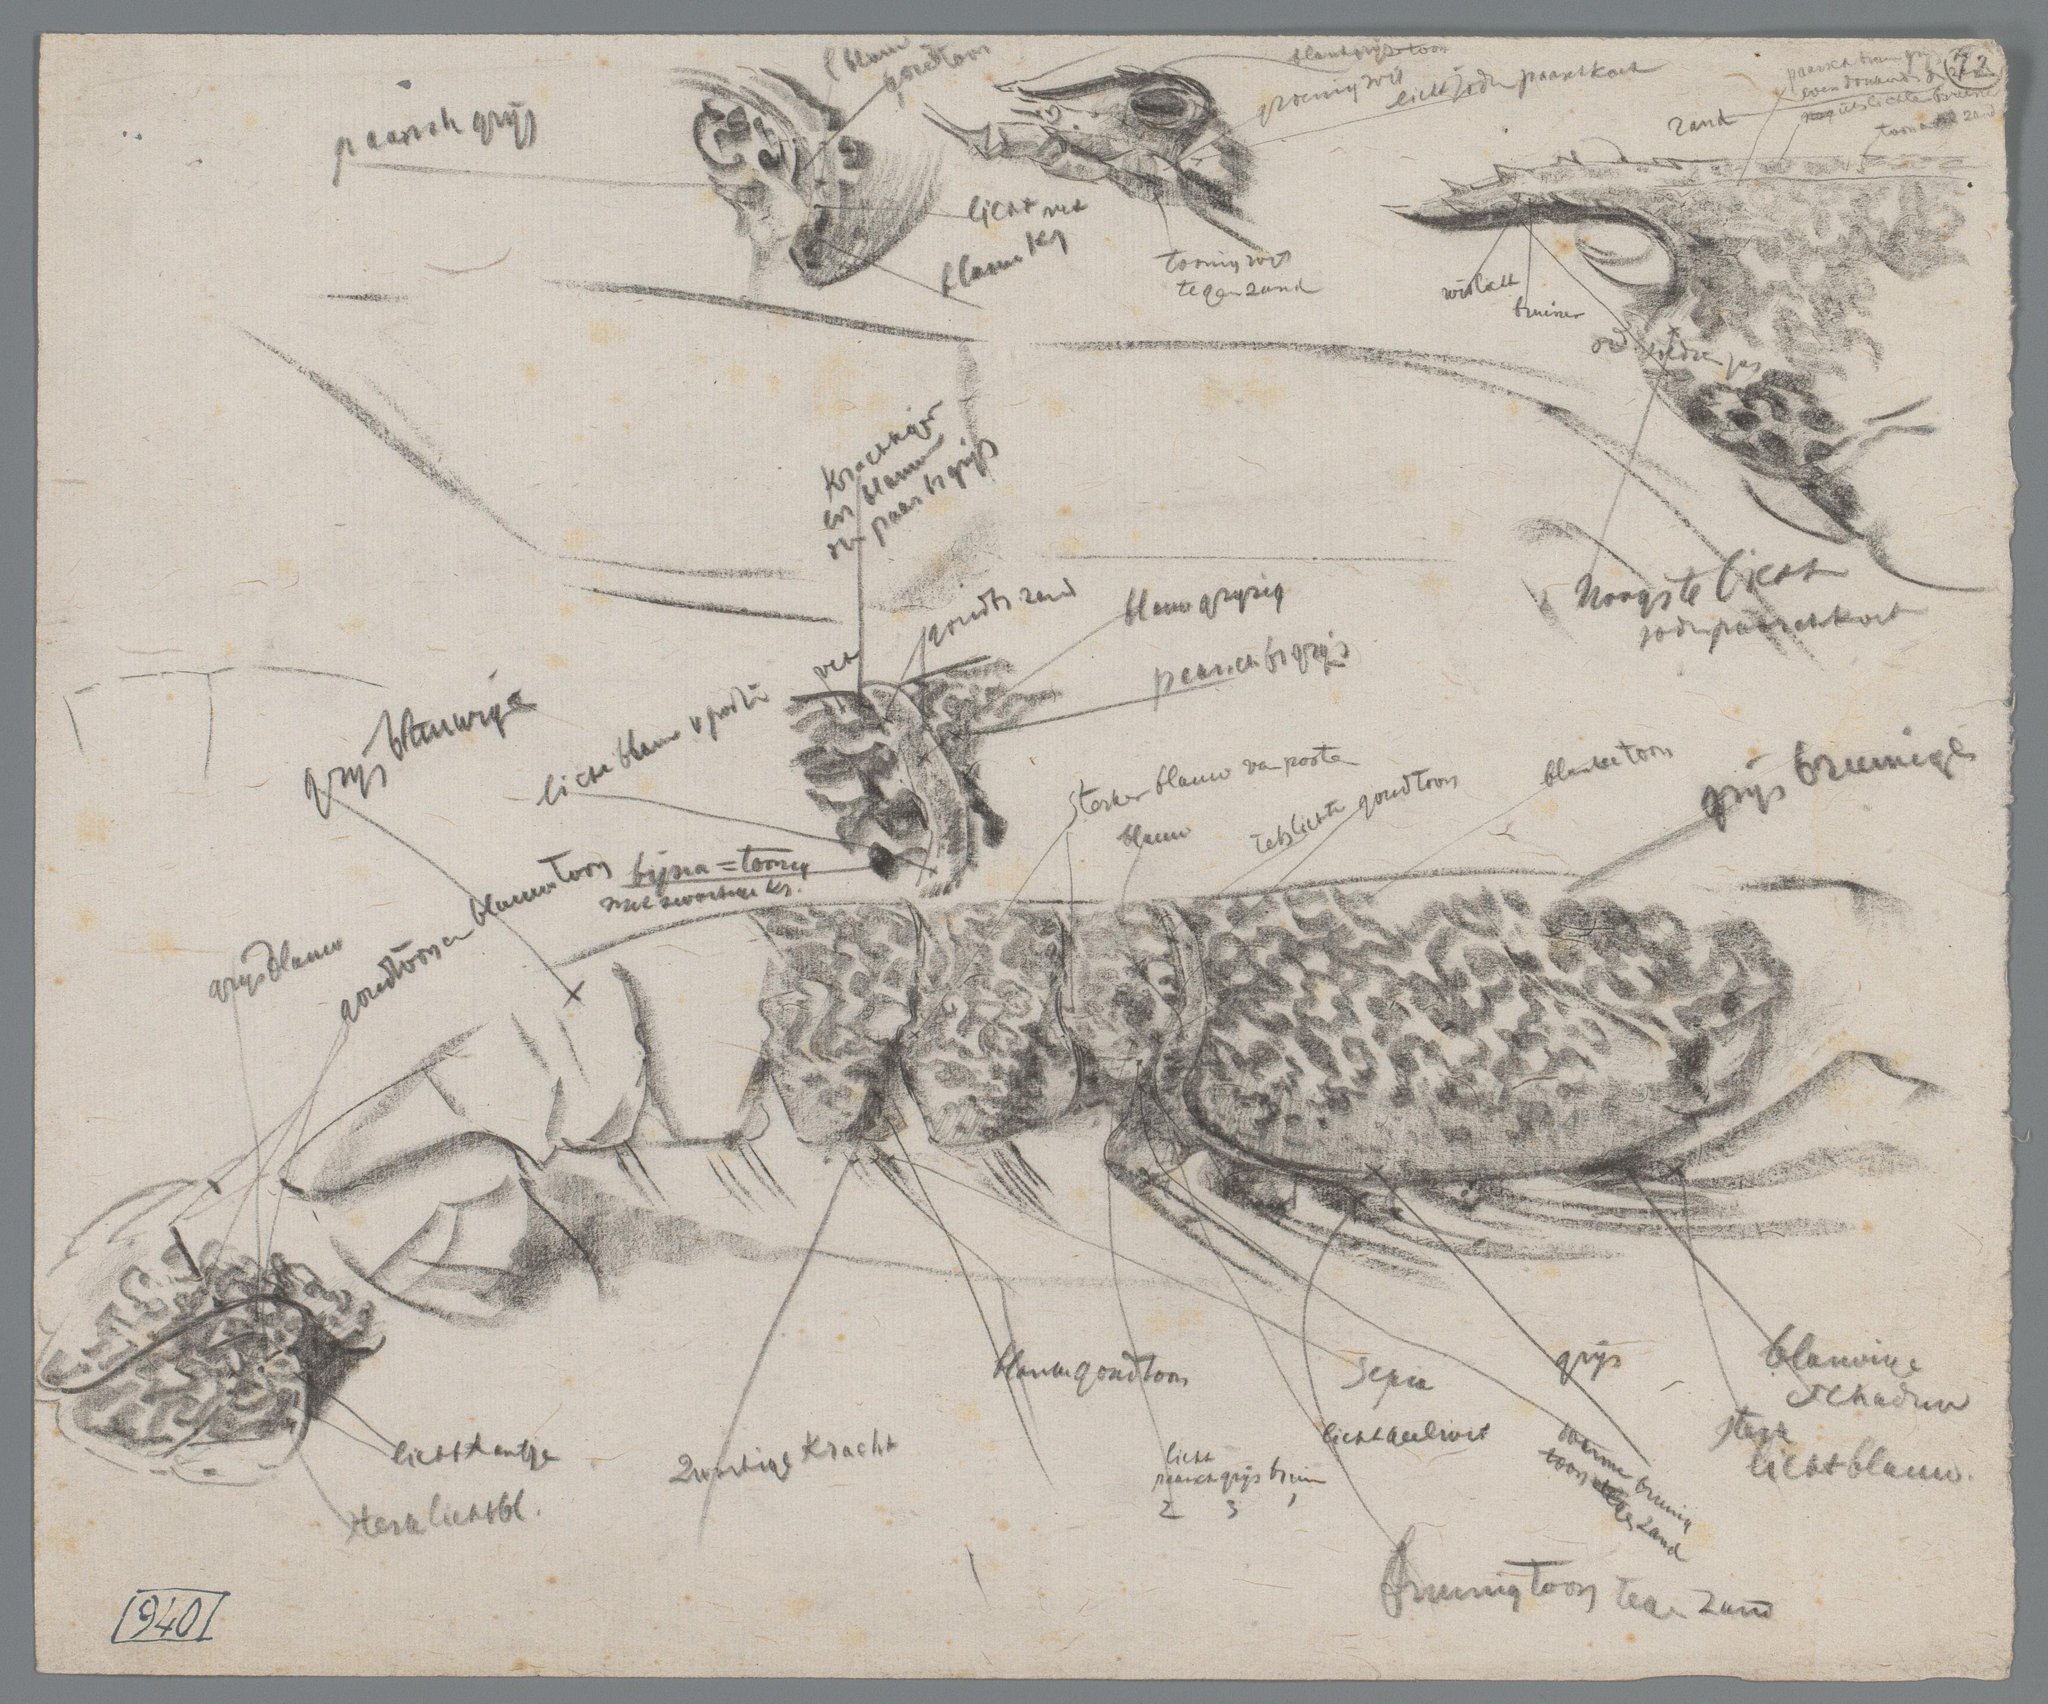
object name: drawing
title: Studies van het kop- en staartstuk van een kreeft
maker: gerrit willem dijsselhof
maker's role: designer, draughtsman, print maker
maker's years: 1866-1924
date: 1876-1924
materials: chalk, paper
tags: crustaceans: lobster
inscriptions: number: ‘940’, number: ‘72’